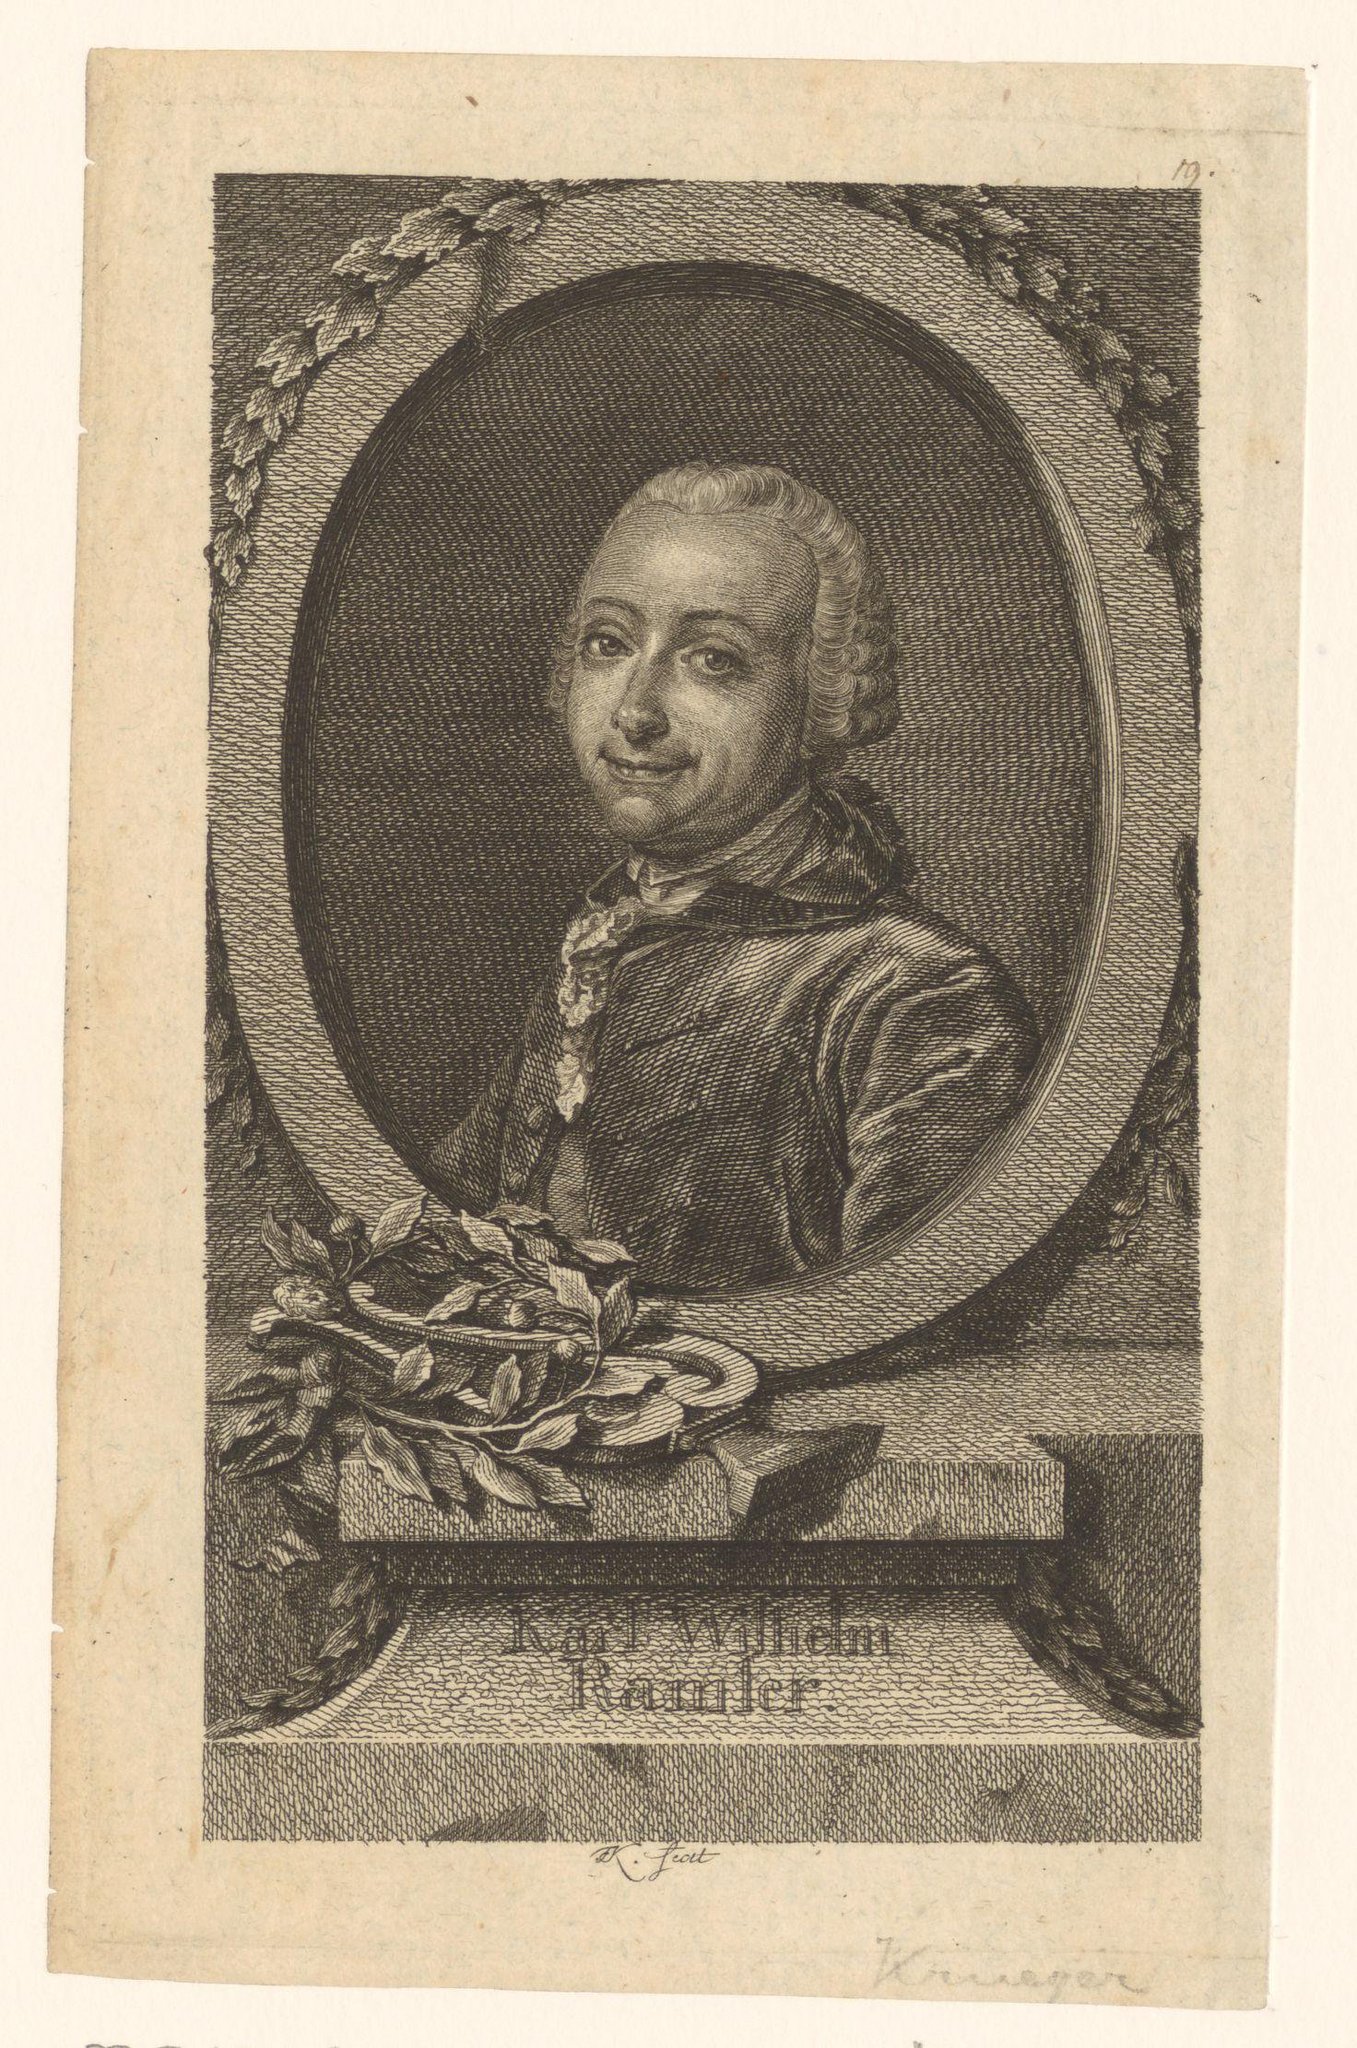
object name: print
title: Portret van Karl Wilhelm Ramler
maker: friedrich johann kauke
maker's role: print maker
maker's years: -1777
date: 1735-1777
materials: paper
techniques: engraving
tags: berlin, translator, historical persons, writer, poet, author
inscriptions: collector's mark: Lugt 2228